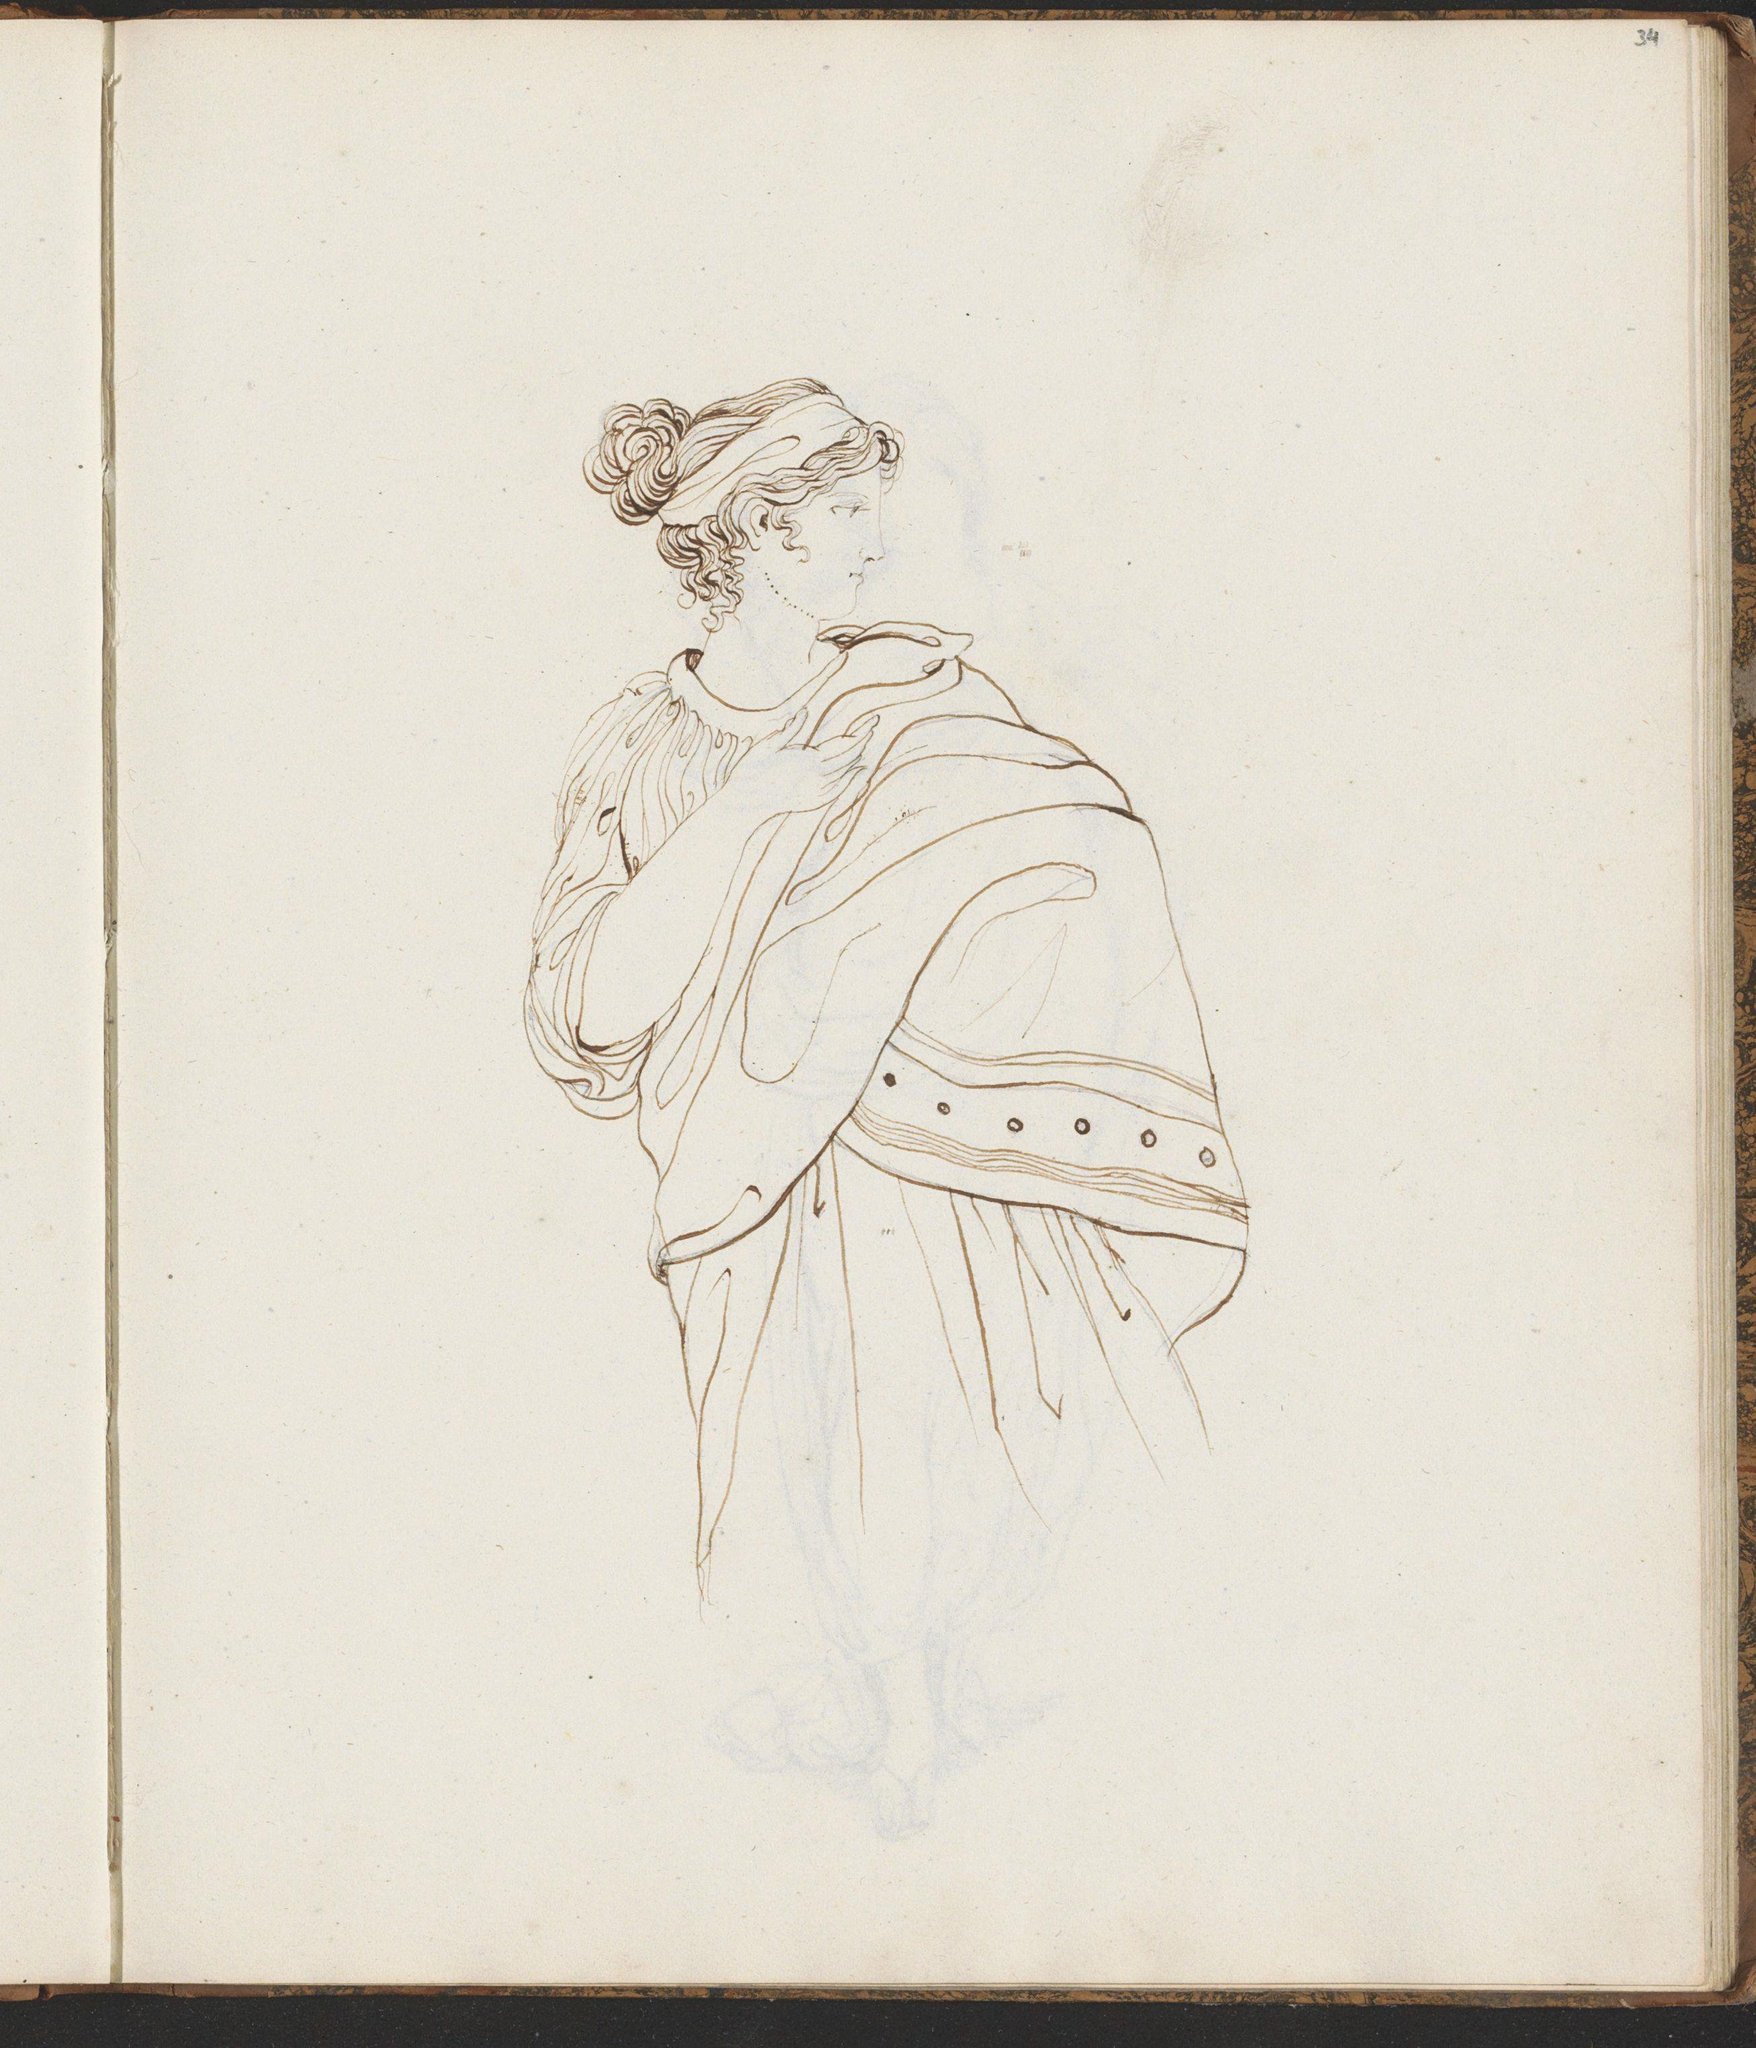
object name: sketchbook leaf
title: Staande vrouw in een toga die over haar schouder kijkt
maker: jonkvrouw catharina kemper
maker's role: draughtsman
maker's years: 1801-1871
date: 1813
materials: ink, paper, pencil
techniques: pen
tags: looking over the shoulder - aa - female human figure, female persons from classical history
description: Vermoedelijk getekend naar klassiek voorbeeld. Blad 34 recto uit een schetsboek met 91 bladen.